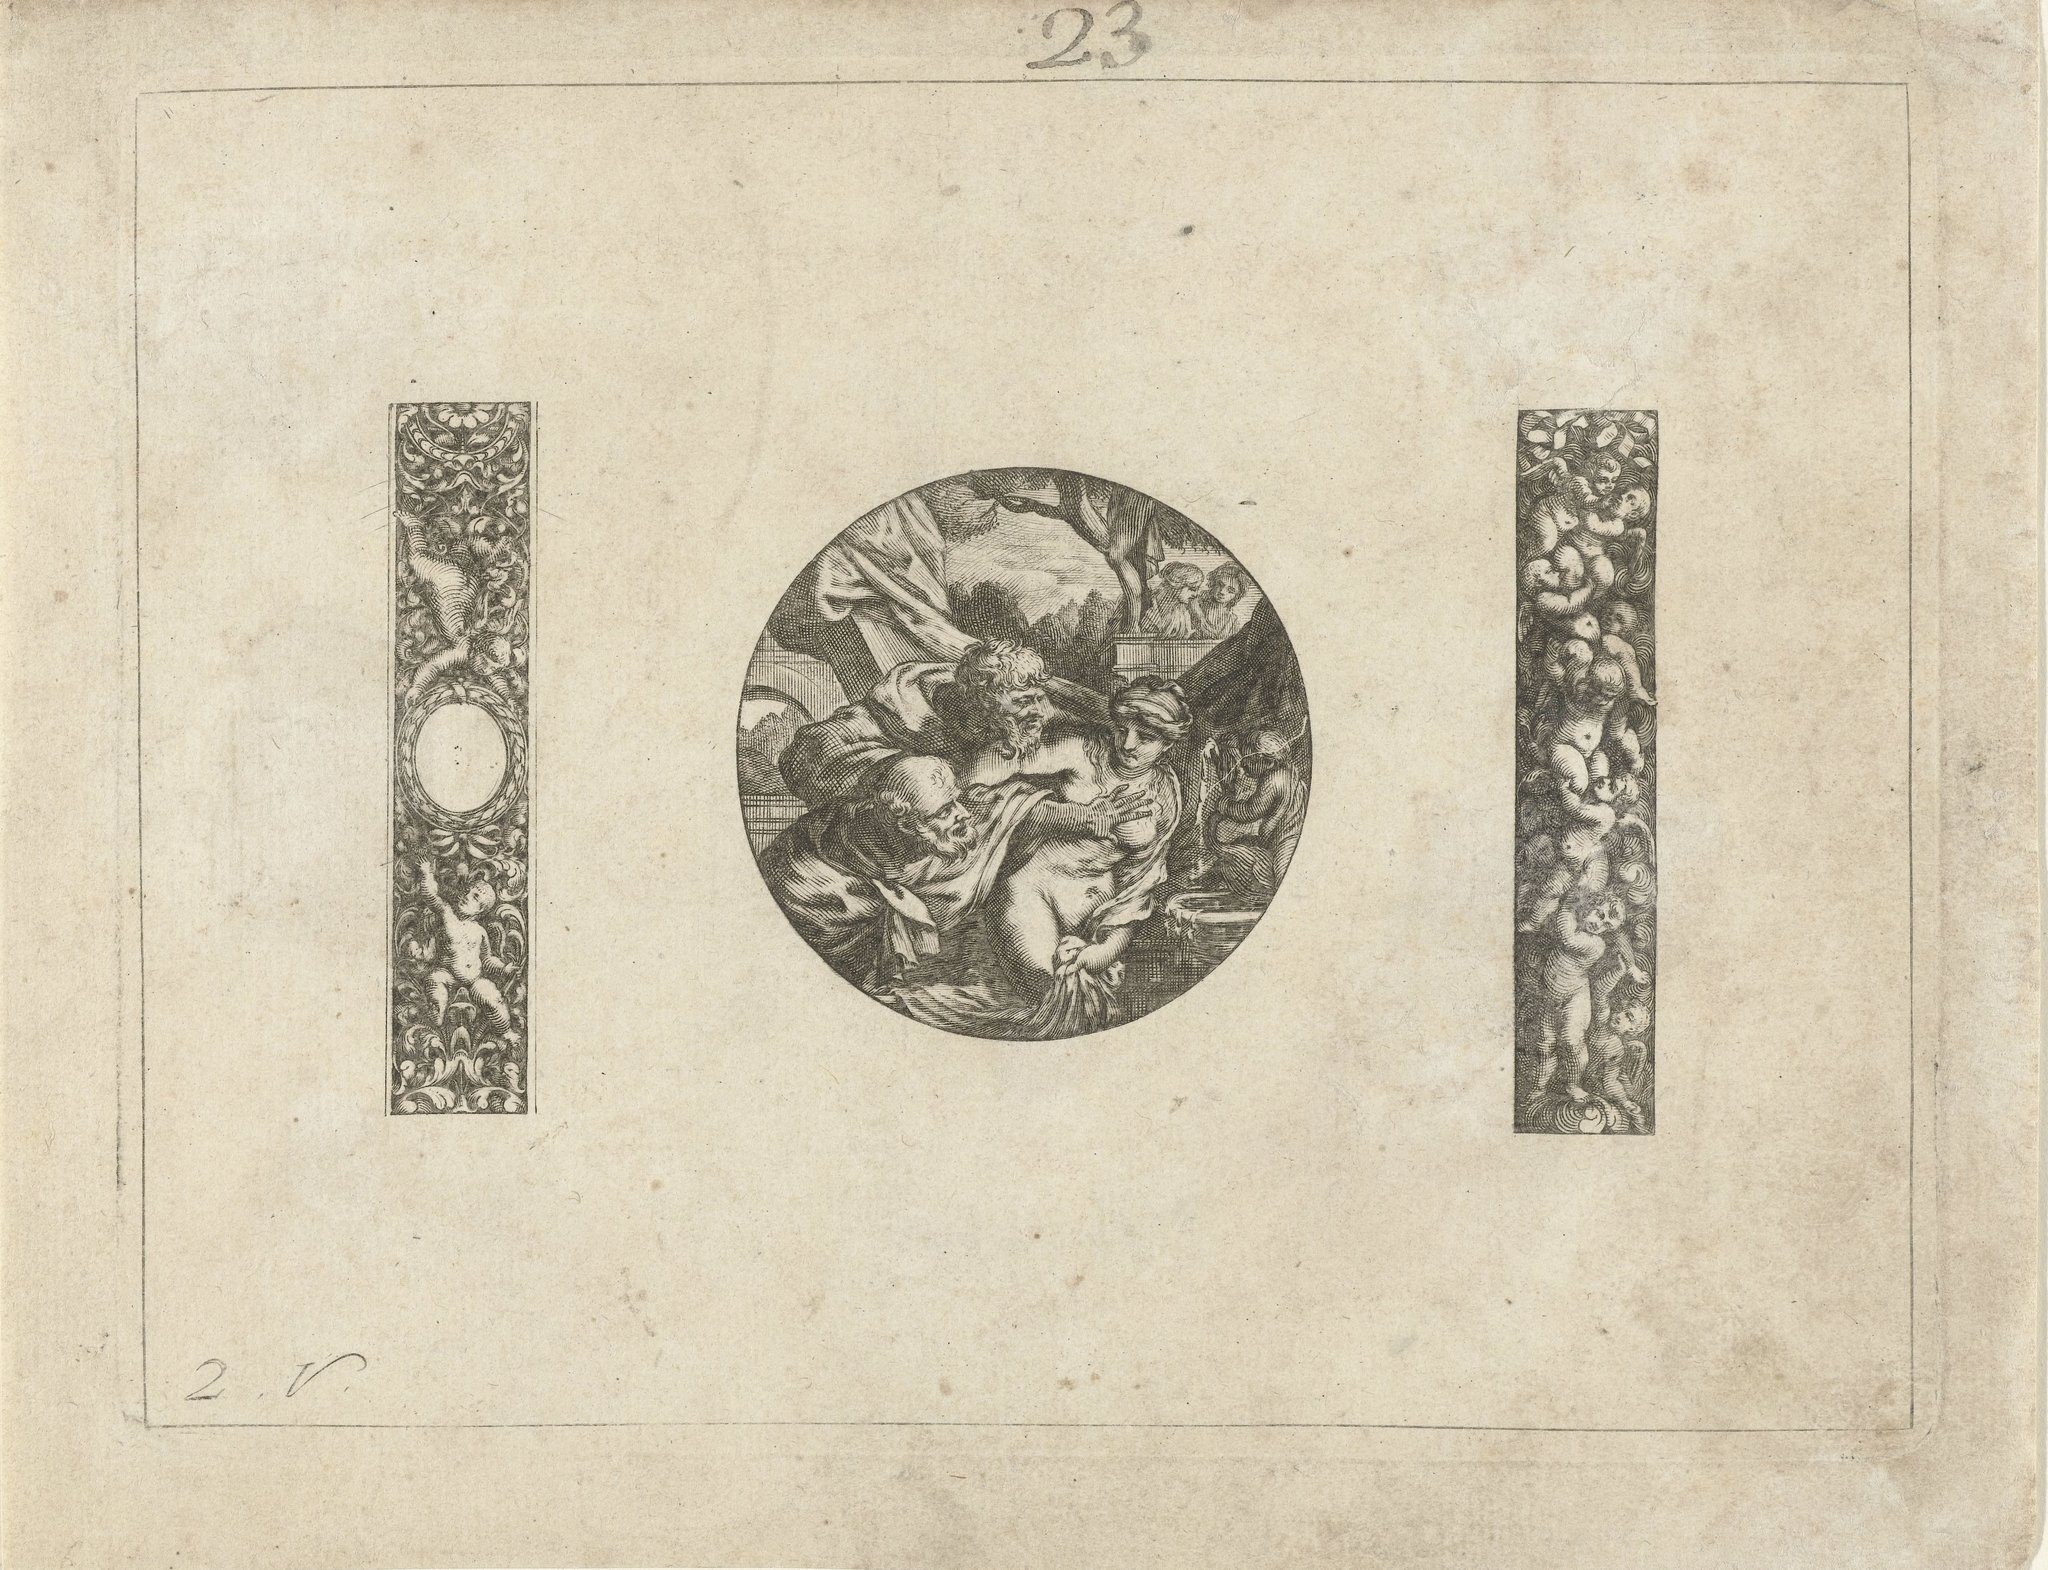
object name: print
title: Horlogekast met twee stroken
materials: paper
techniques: engraving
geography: france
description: Horlogekast met Susanna en de Ouderlingen. Eerste editie, tweede druk.